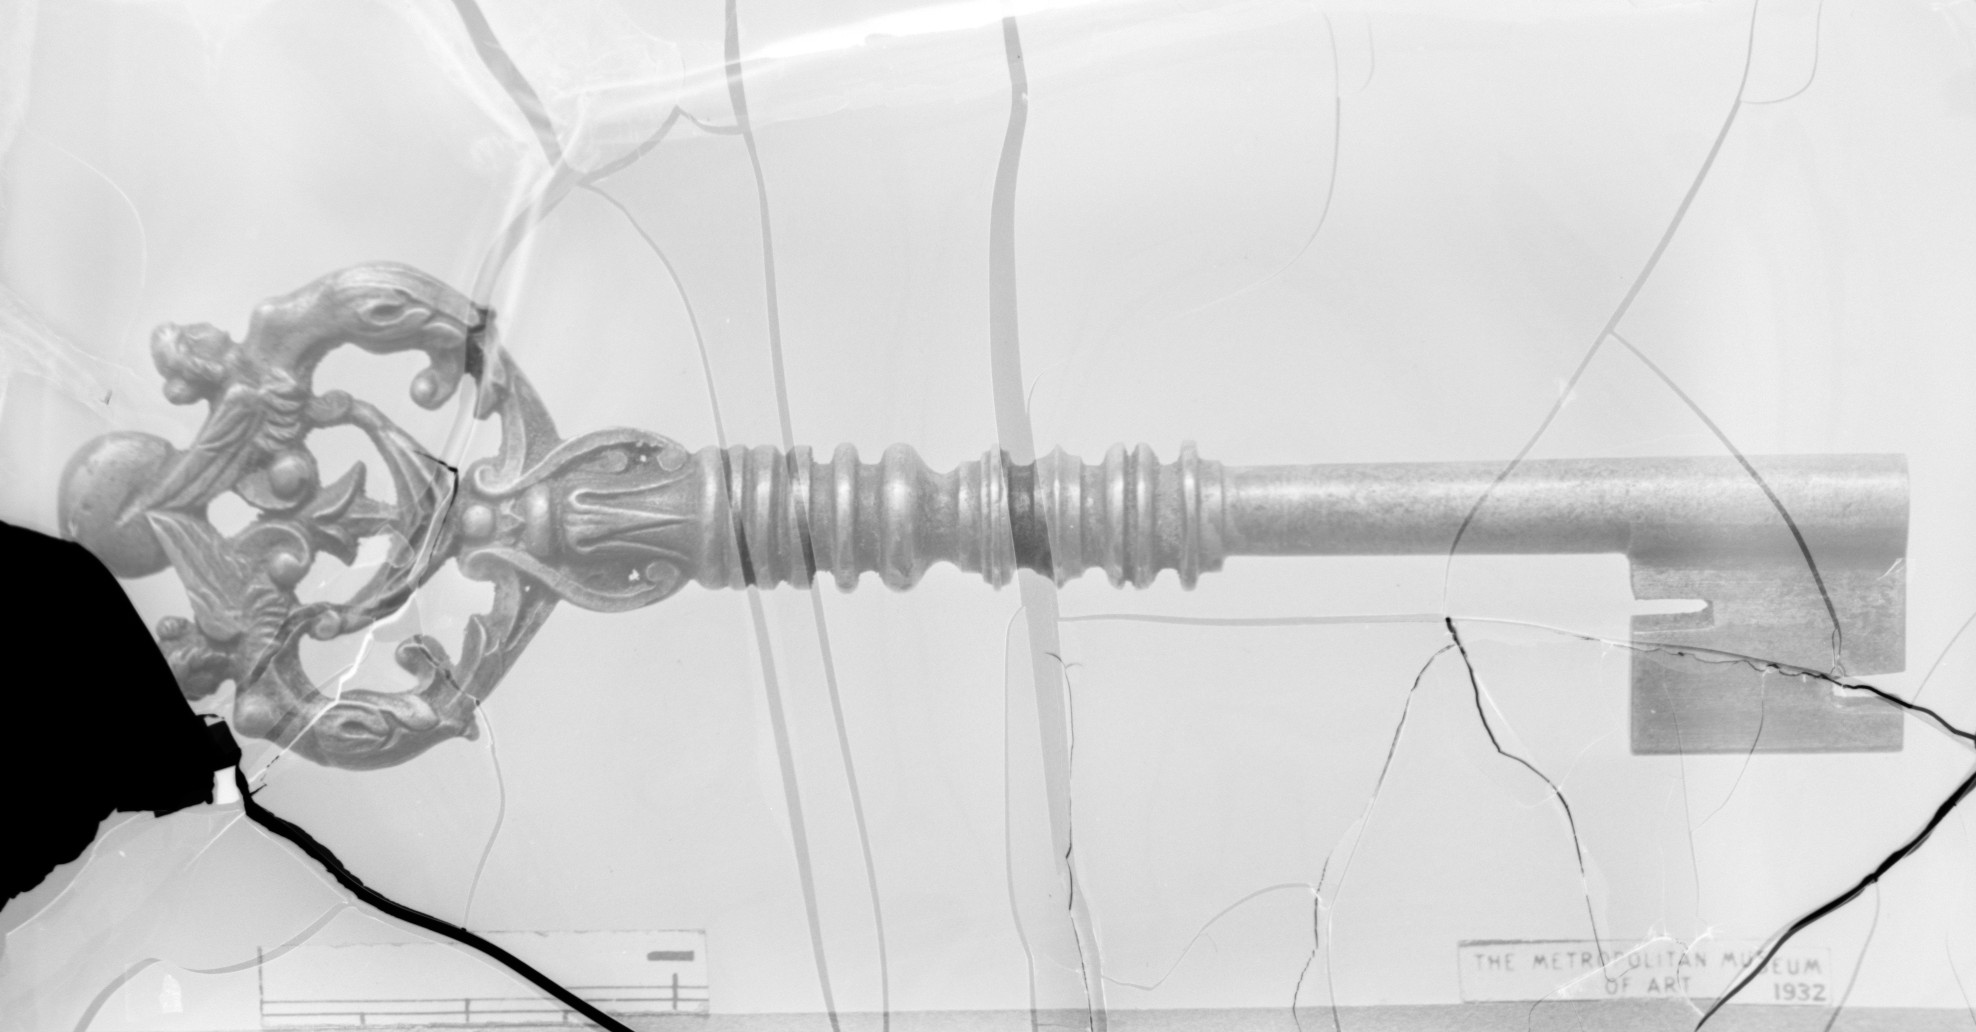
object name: key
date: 1601-1700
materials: iron